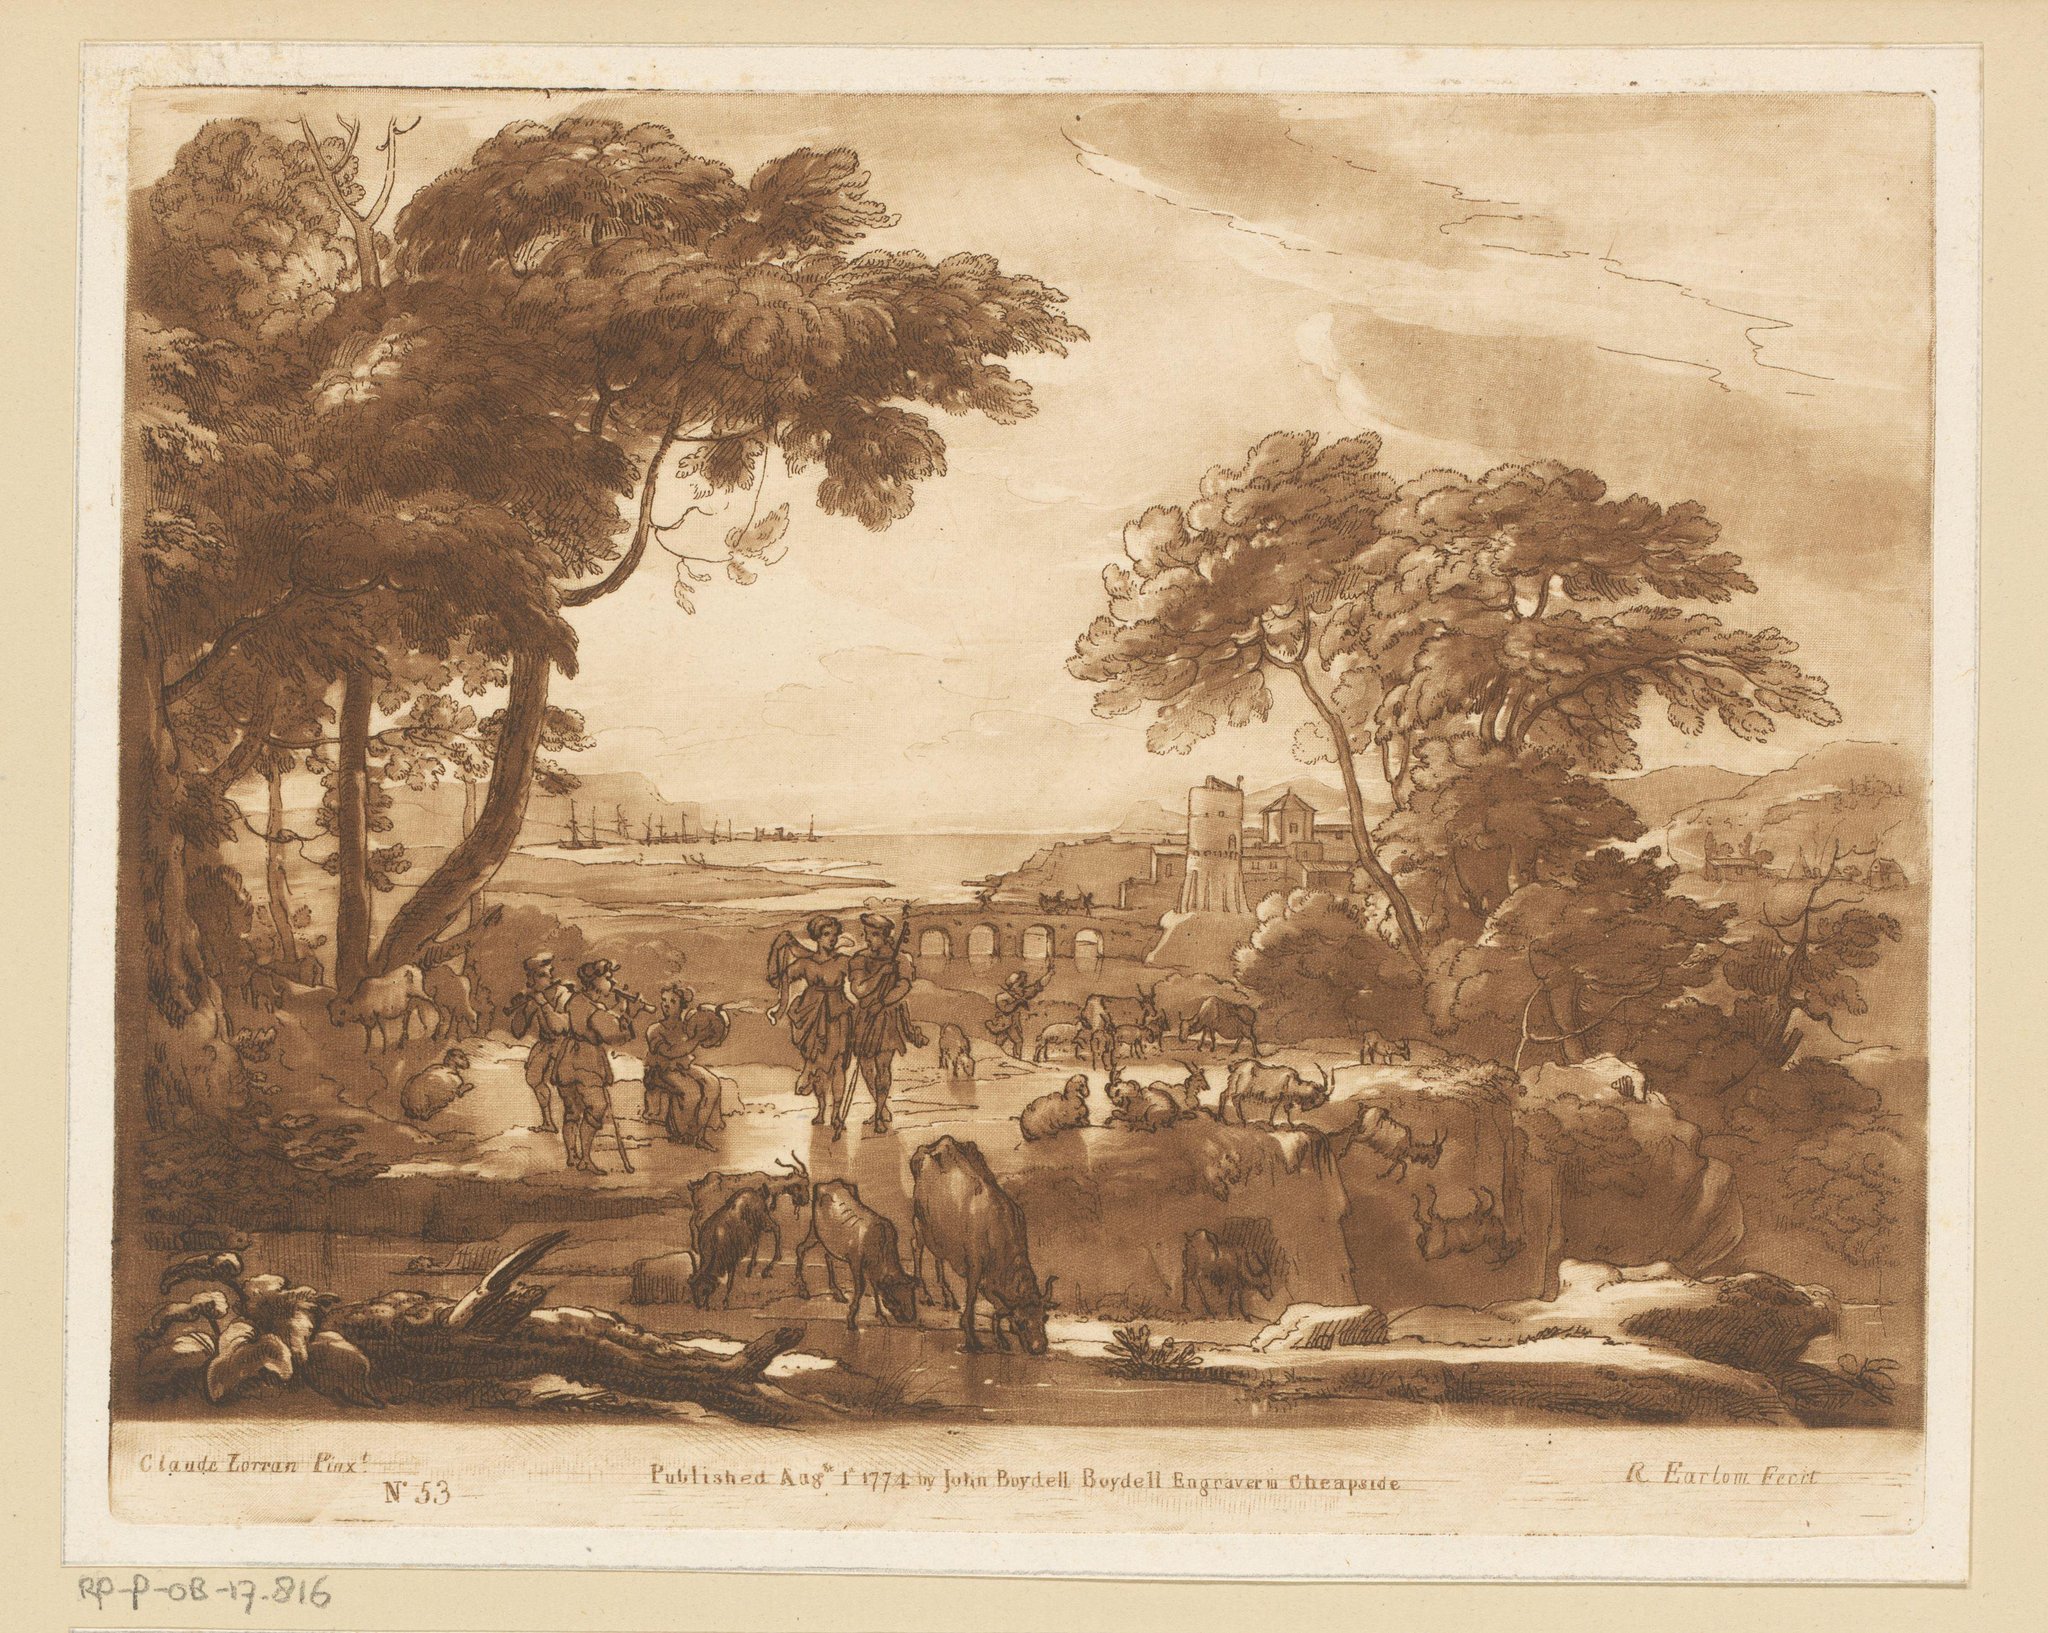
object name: print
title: Prenten naar tekeningen van Claude Lorrain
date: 1774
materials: paper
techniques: etching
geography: london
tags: inland cliff face (+ landscape with figures, staffage), landscape with bridge, viaduct or aqueduct, making music; musician with instrument - cc - out of doors, landscape with tower or castle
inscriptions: date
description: Vanaf 1774 publiceerde John Boydell tweehonderd prenten naar het tekeningenboek Liber Veritatis van Claude Lorrain, in het bezit van de hertogen van Cavendish. Deze prenten werden vanaf 1777 in twee volumes gebundeld uitgegeven.